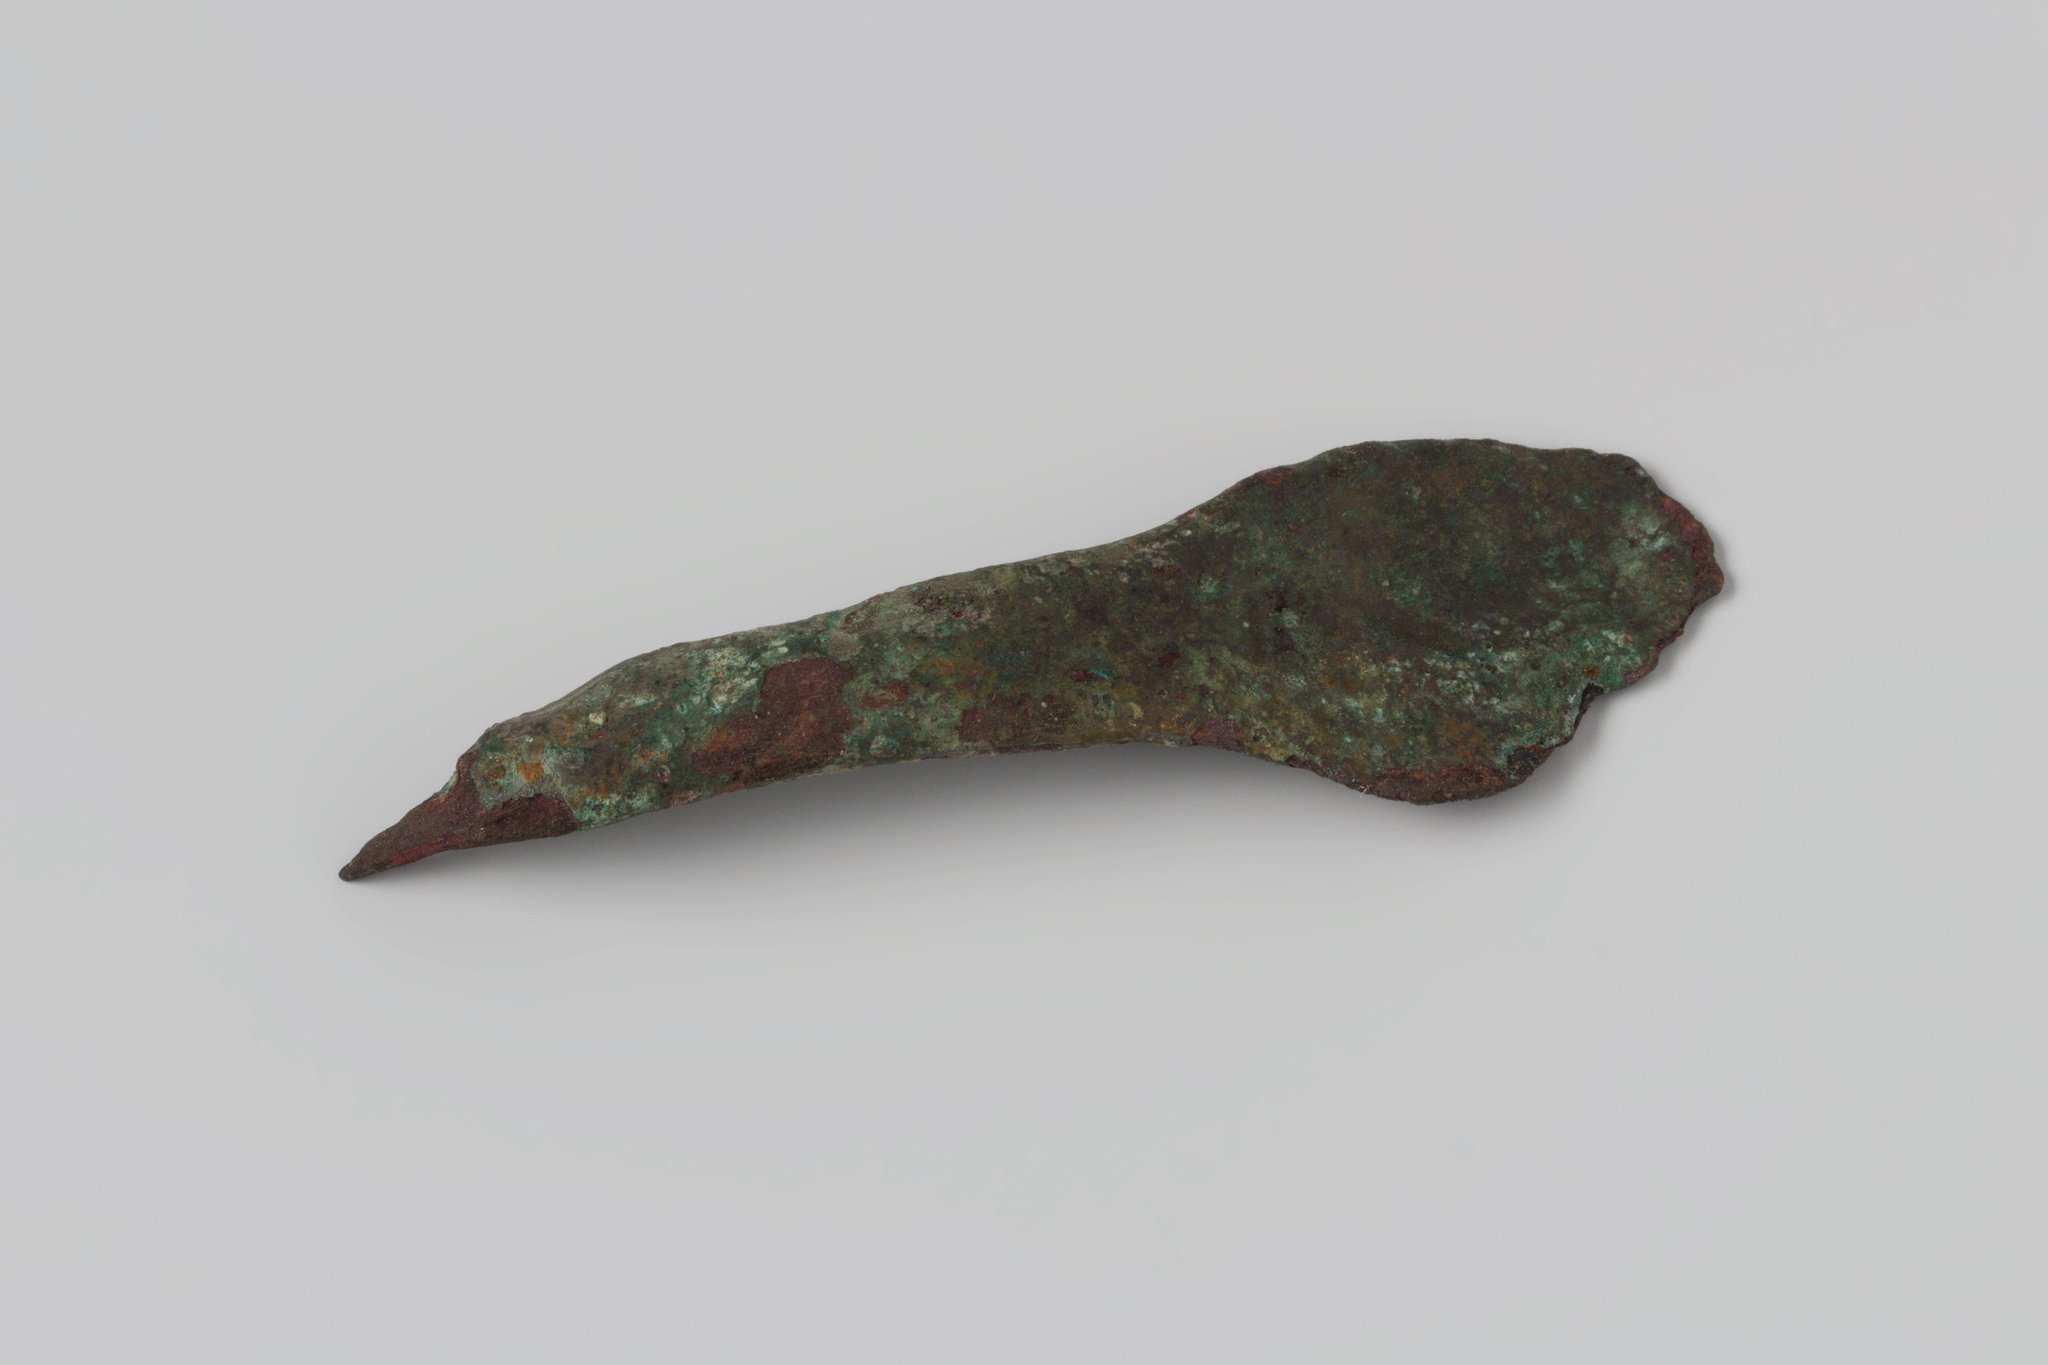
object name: scheepswrakvondst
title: Fragment van koper uit het wrak van de Oost-Indiëvaarder Hollandia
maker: Anonymous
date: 1700-1743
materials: copper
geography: netherlands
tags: verenigde oostindische compagnie, hollandia (schip), annet